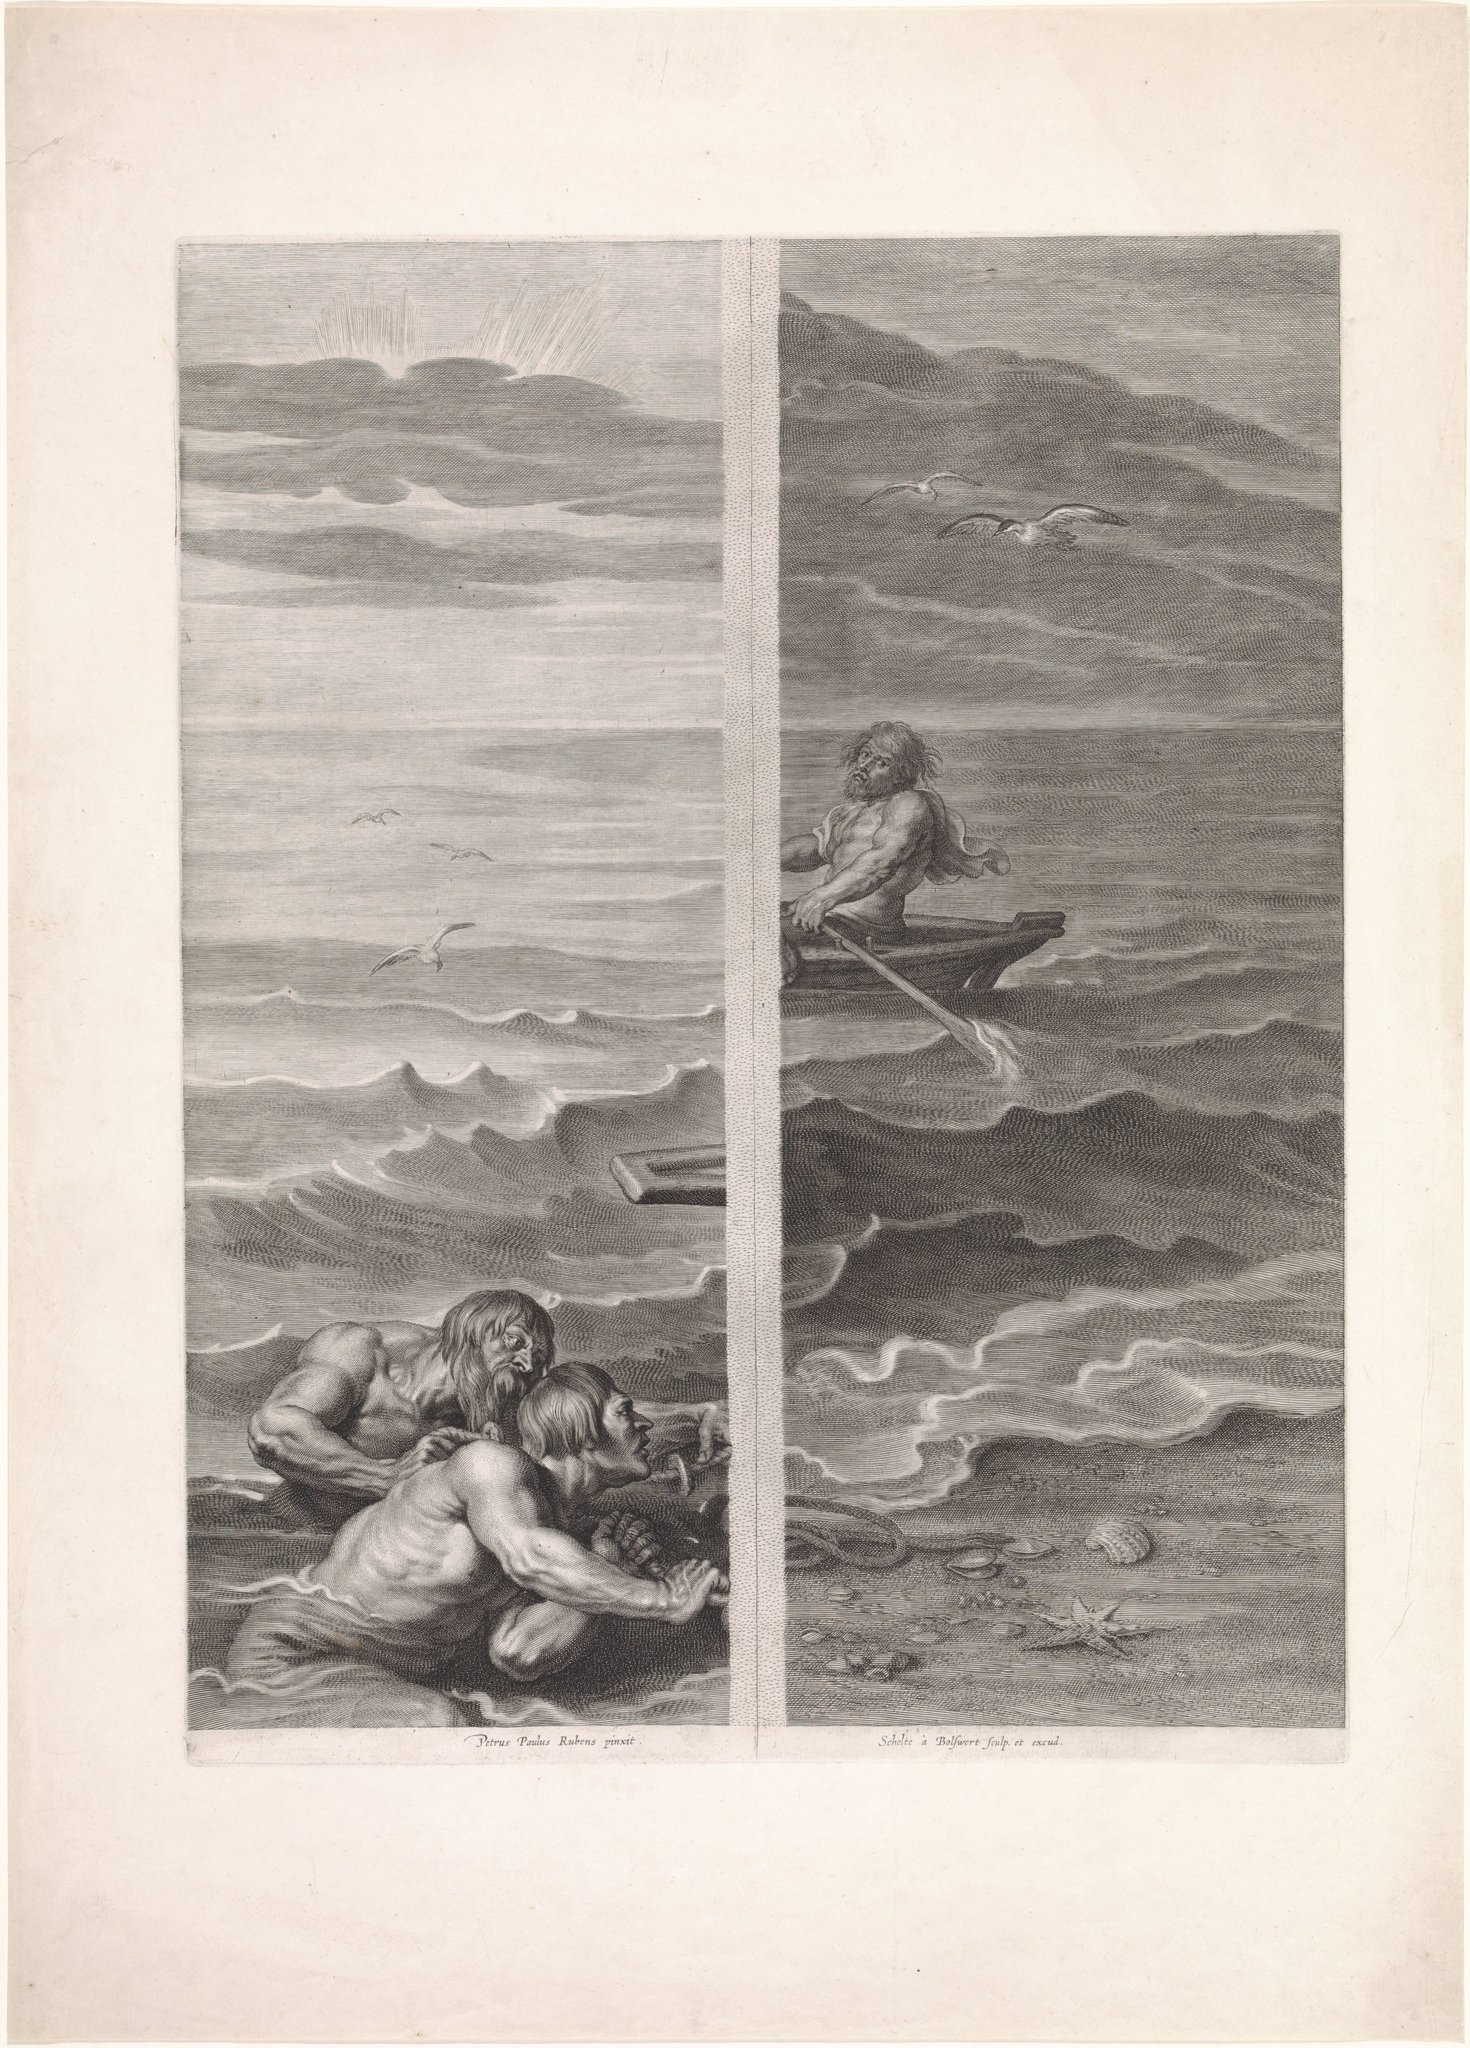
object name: print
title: De wonderbare visvangst (linker en rechter plaat)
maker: schelte adamsz. bolswert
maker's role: print maker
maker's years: 1586-1659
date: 1596-1659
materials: paper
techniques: engraving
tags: the miraculous draught of fishes (before the resurrection) on the lake of gennesaret (sea of galilee); james and john helping to bring in the nets (luke 5:1-11)